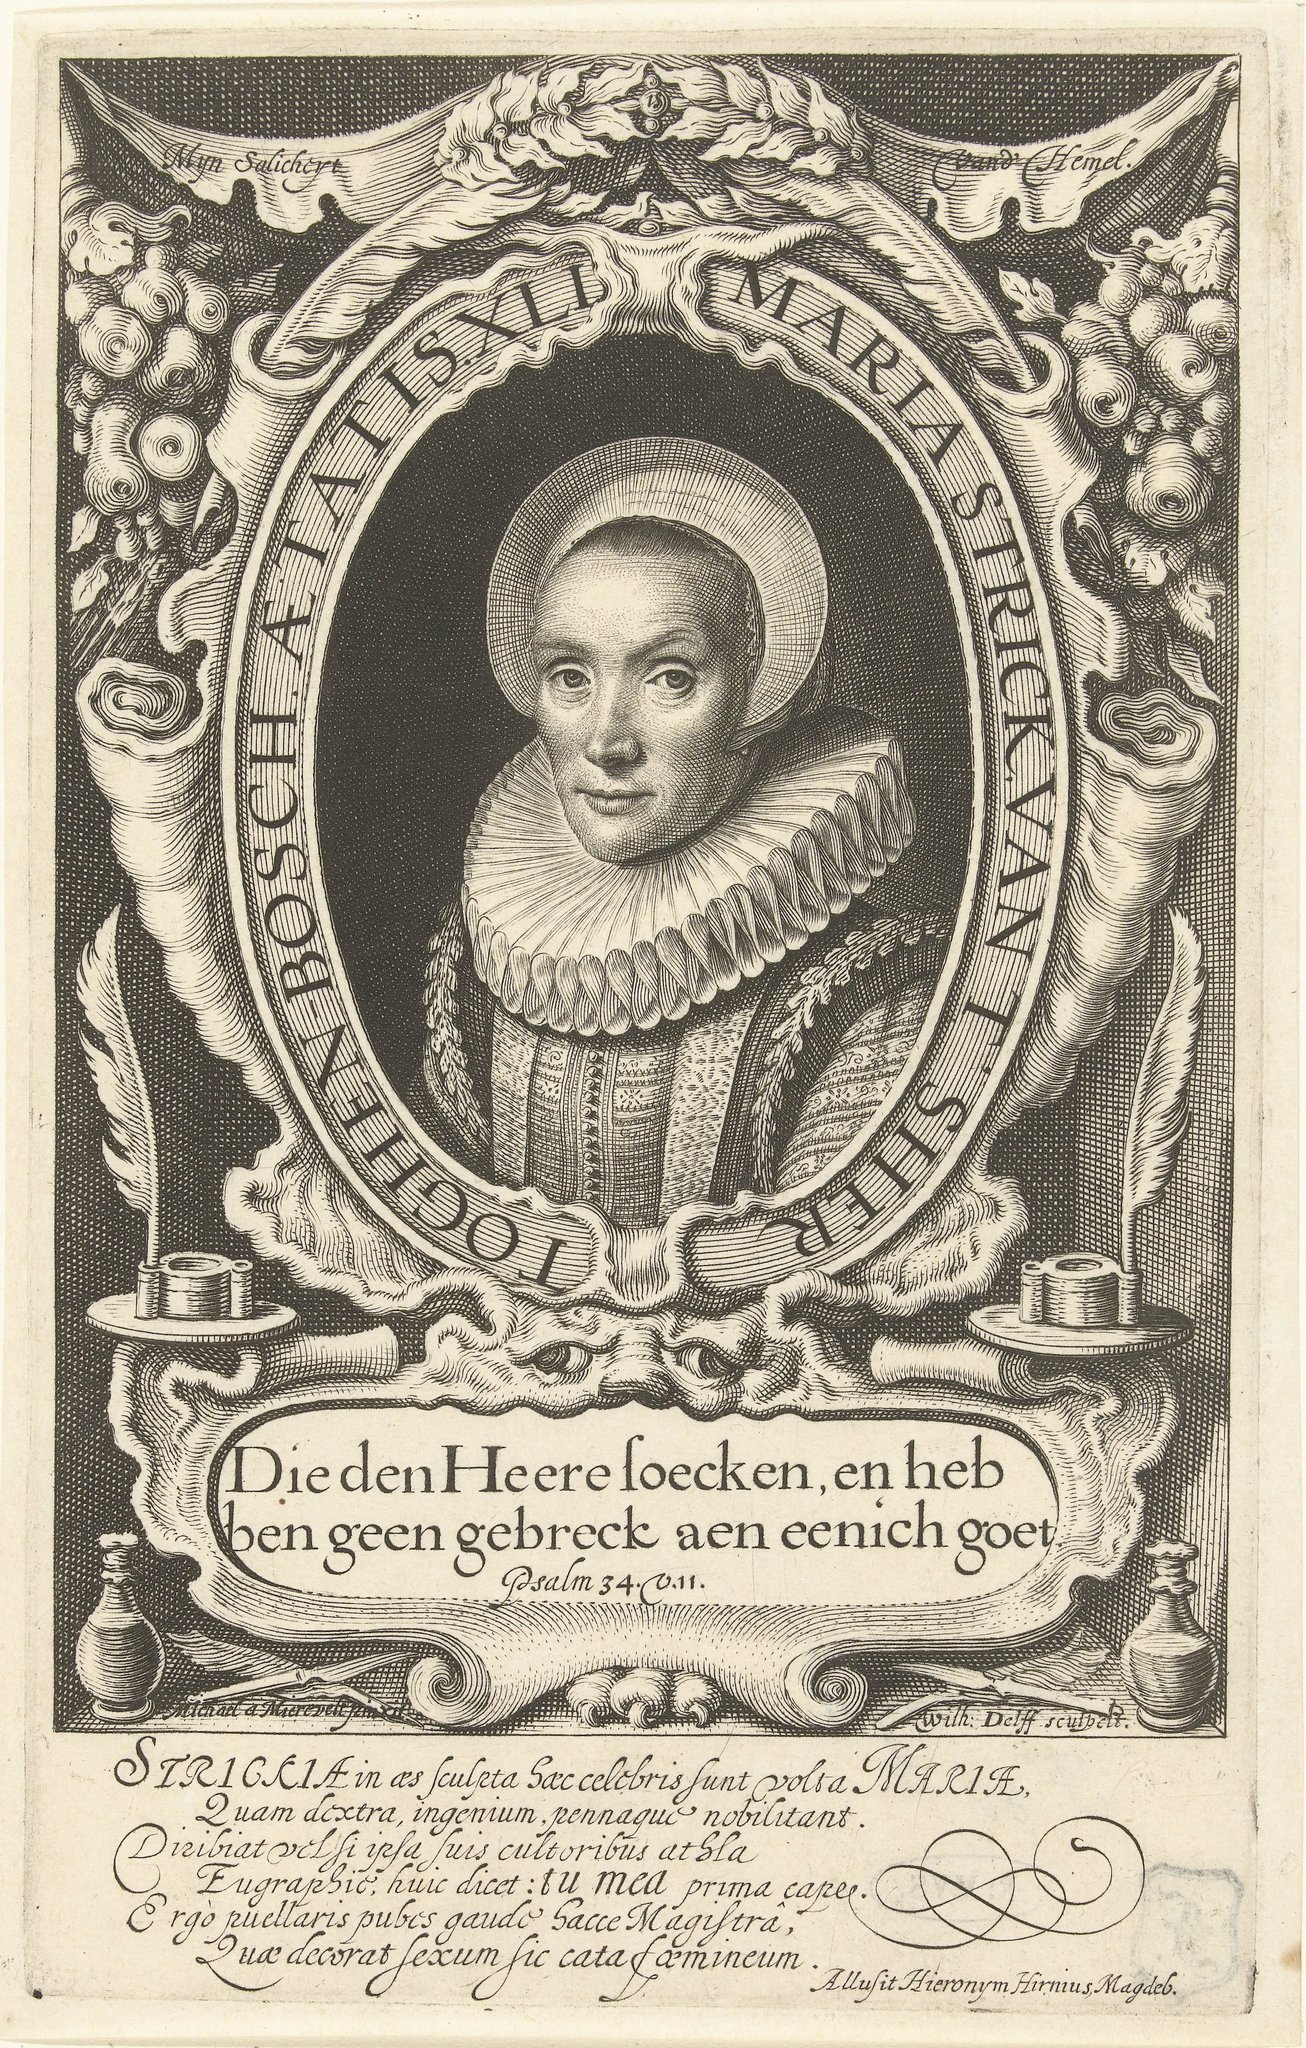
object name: print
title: Portret van Maria Strick op 41-jarige leeftijd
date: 1618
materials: paper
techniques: engraving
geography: delft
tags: den bosch, rotterdam, maria strick, scholastic education, tuition (+ teacher, professor)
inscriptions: collector's mark: Lugt 963, collector's mark: Lugt 2228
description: Portret van schoonschrijfster en onderwijzeres Maria Strick op 41-jarige leeftijd, borststuk met molenkraag en muts in ovale cartouche bekroond met palmbladeren en versierd met fruit. Onder portret cartouche met links en rechts inktpot en ganzenveer en regel tekst uit Psalm 34. In ondermarge Latijns vers in zes regels.